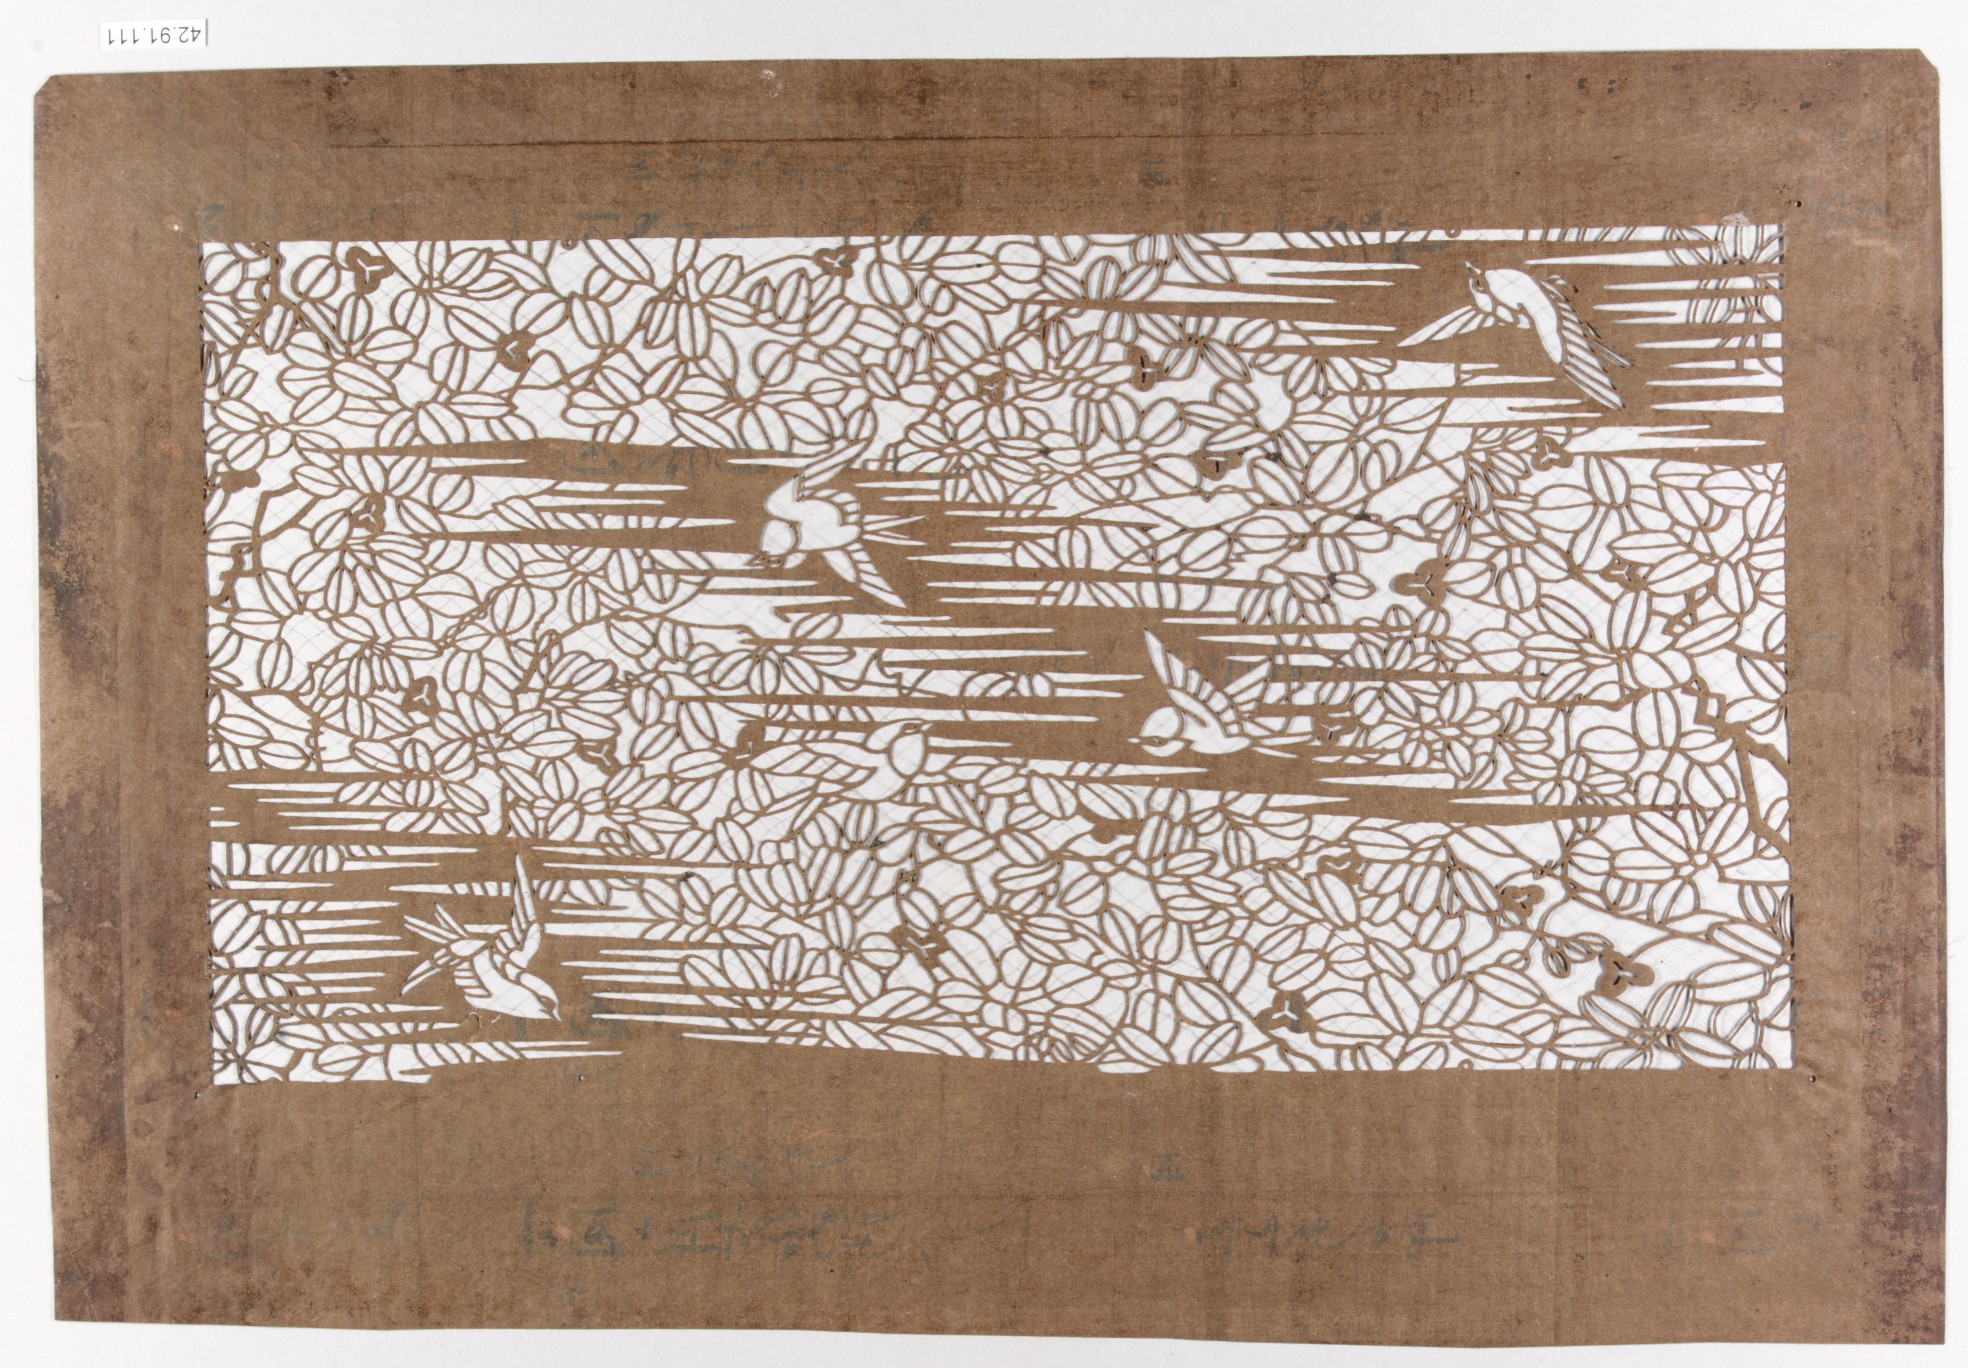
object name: stencil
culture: japanese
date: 1801-1900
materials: paper, silk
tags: birds